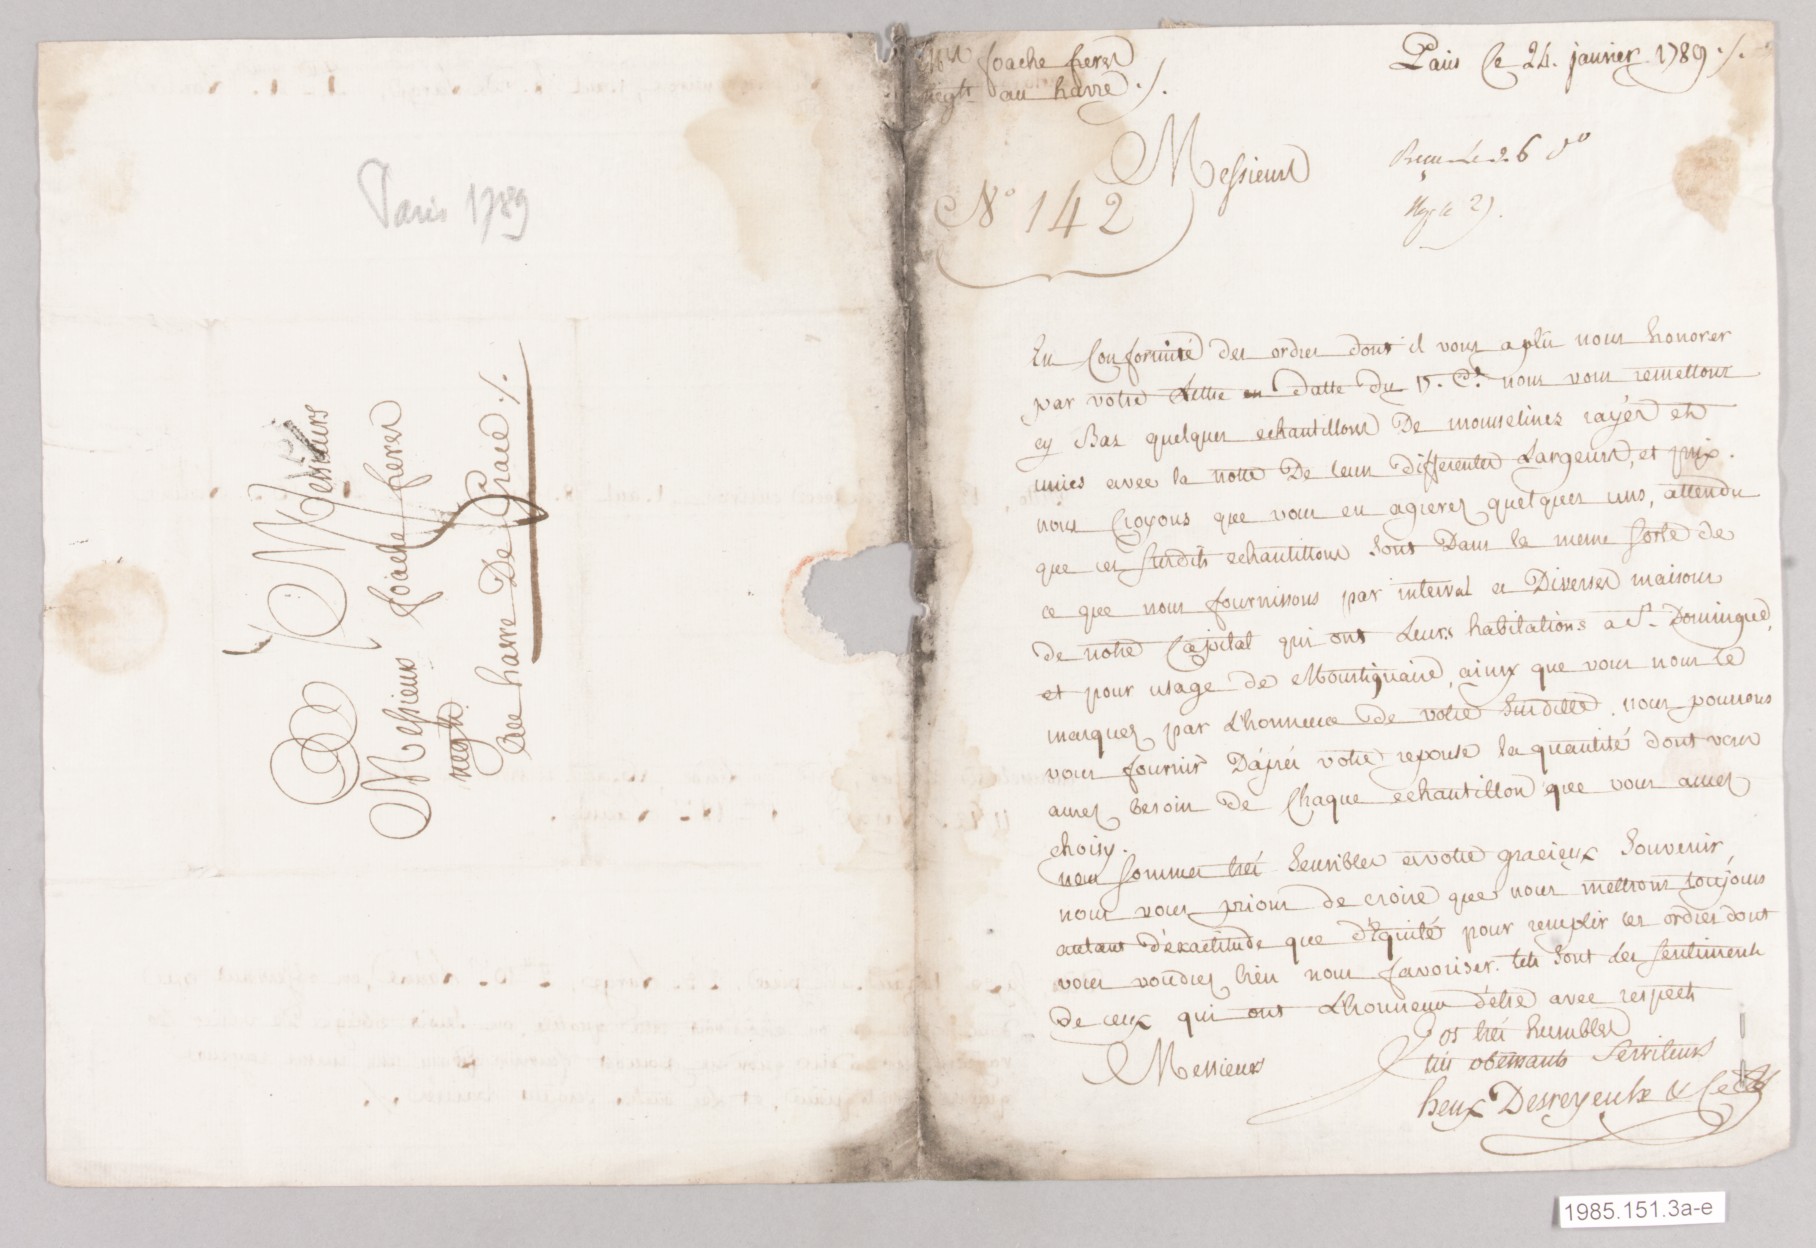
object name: sample and letter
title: Textile swatch to accompany letter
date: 1767-1800